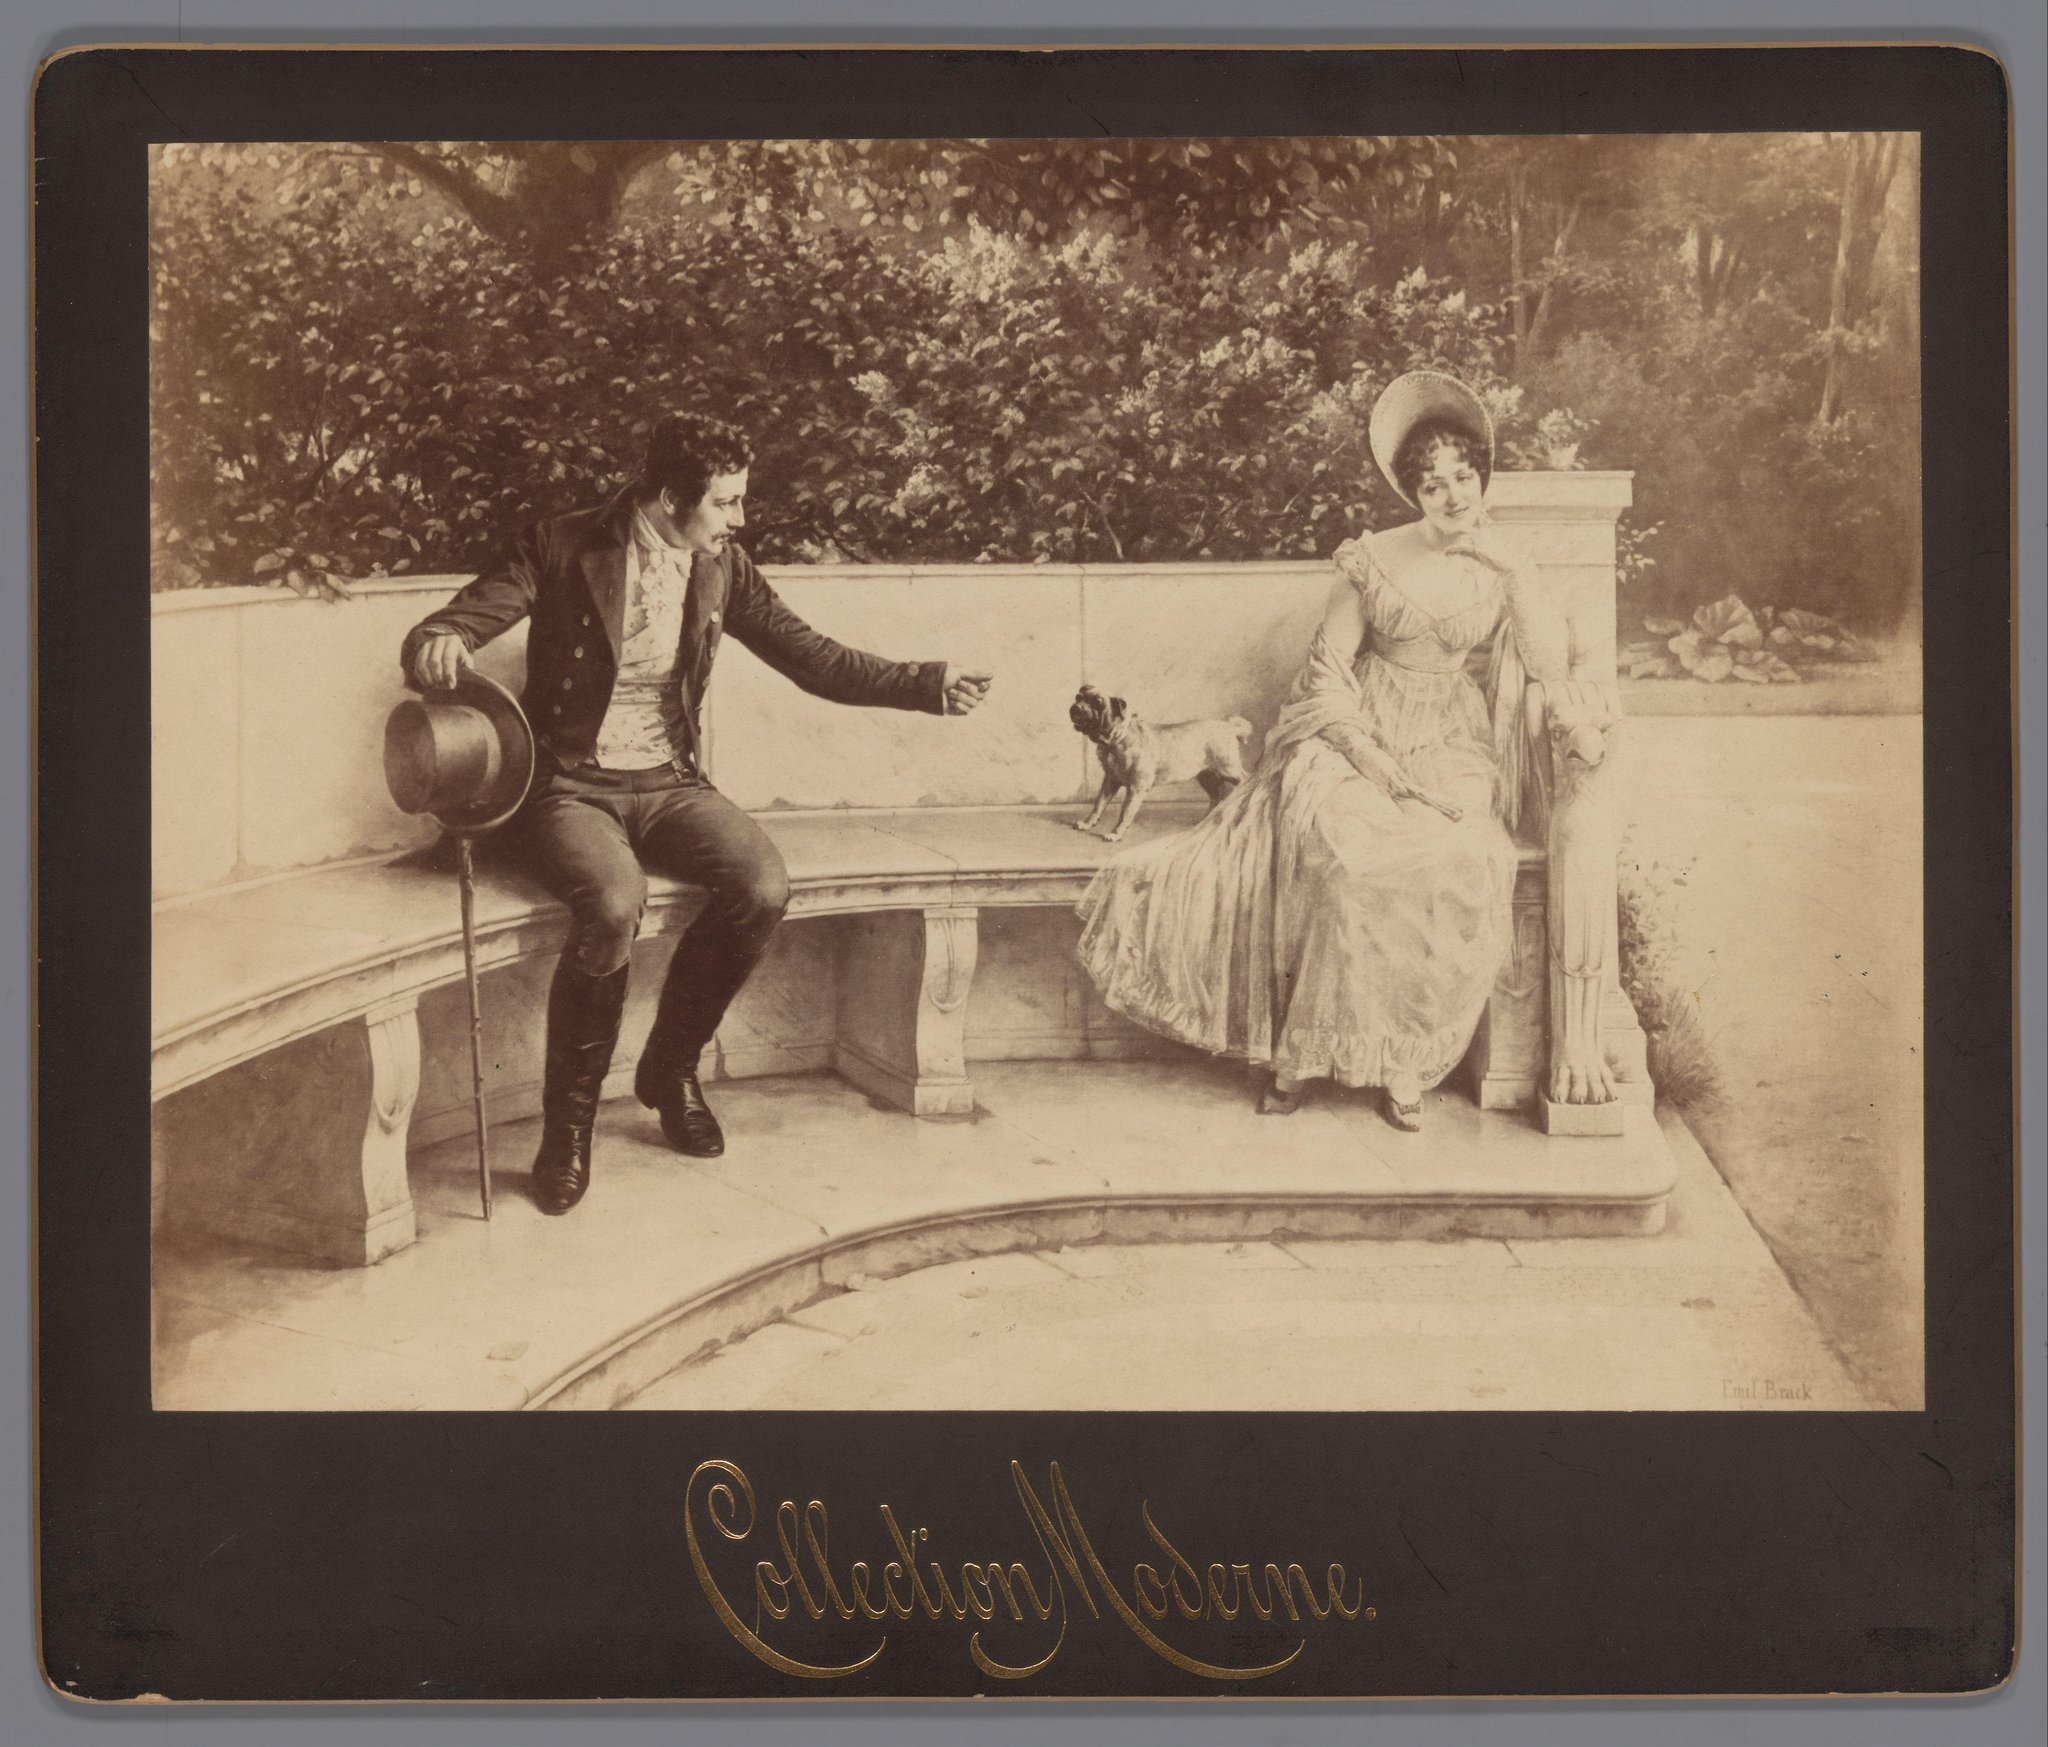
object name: reproduction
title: Fotoreproductie van het schilderij Love me, love my dog door Emil Brack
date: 1890-1920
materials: cardboard, paper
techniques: albumen print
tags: picture, painting, lovers; courting, flirting, dog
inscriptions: inscription: ‘E. BRACK./ Love me, love my dog.’